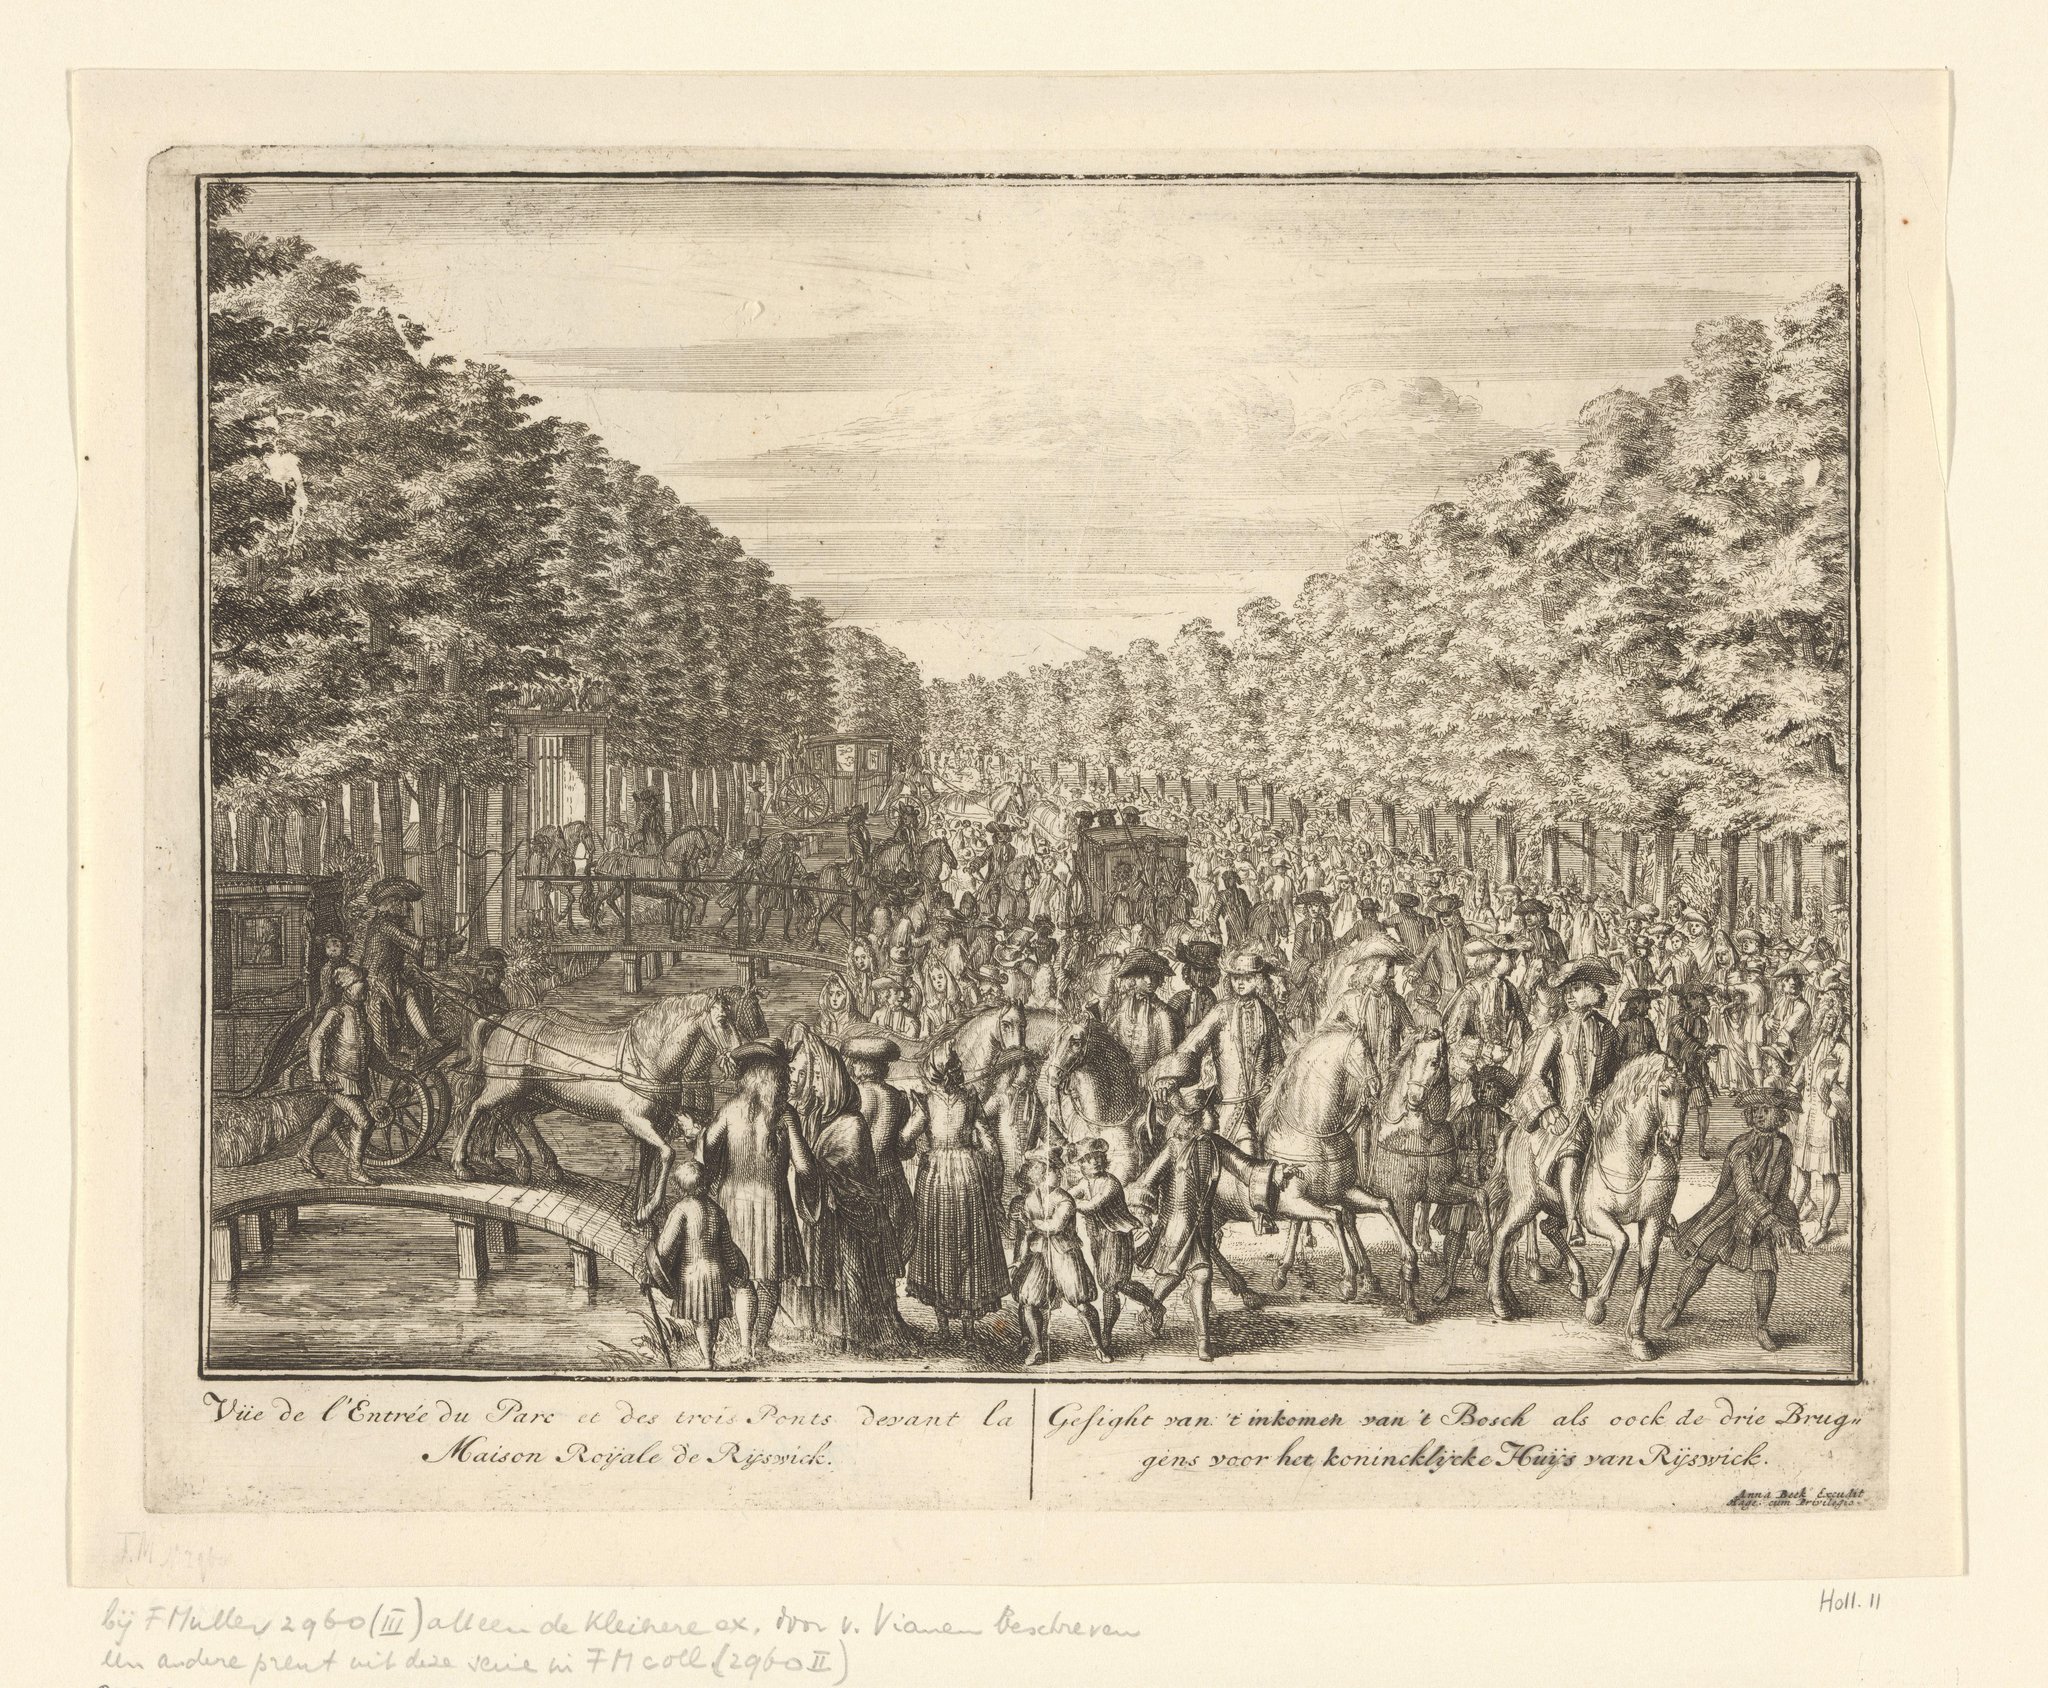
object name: print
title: Gezicht op de boslaan met de drie bruggen voor het Huis ter Nieuburch in Rijswijk, 1697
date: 1697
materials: paper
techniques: etching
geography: the hague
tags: palace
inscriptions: collector's mark: Lugt 2228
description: Boslaan met de drie bruggen met koetsen en veel publiek voor het Huis ter Nieuburch in Rijswijk. Onderdeel van de serie van vijftien prenten over het Huis ter Nieuburch in Rijswijk en de daar gehouden vredesonderhandelingen.